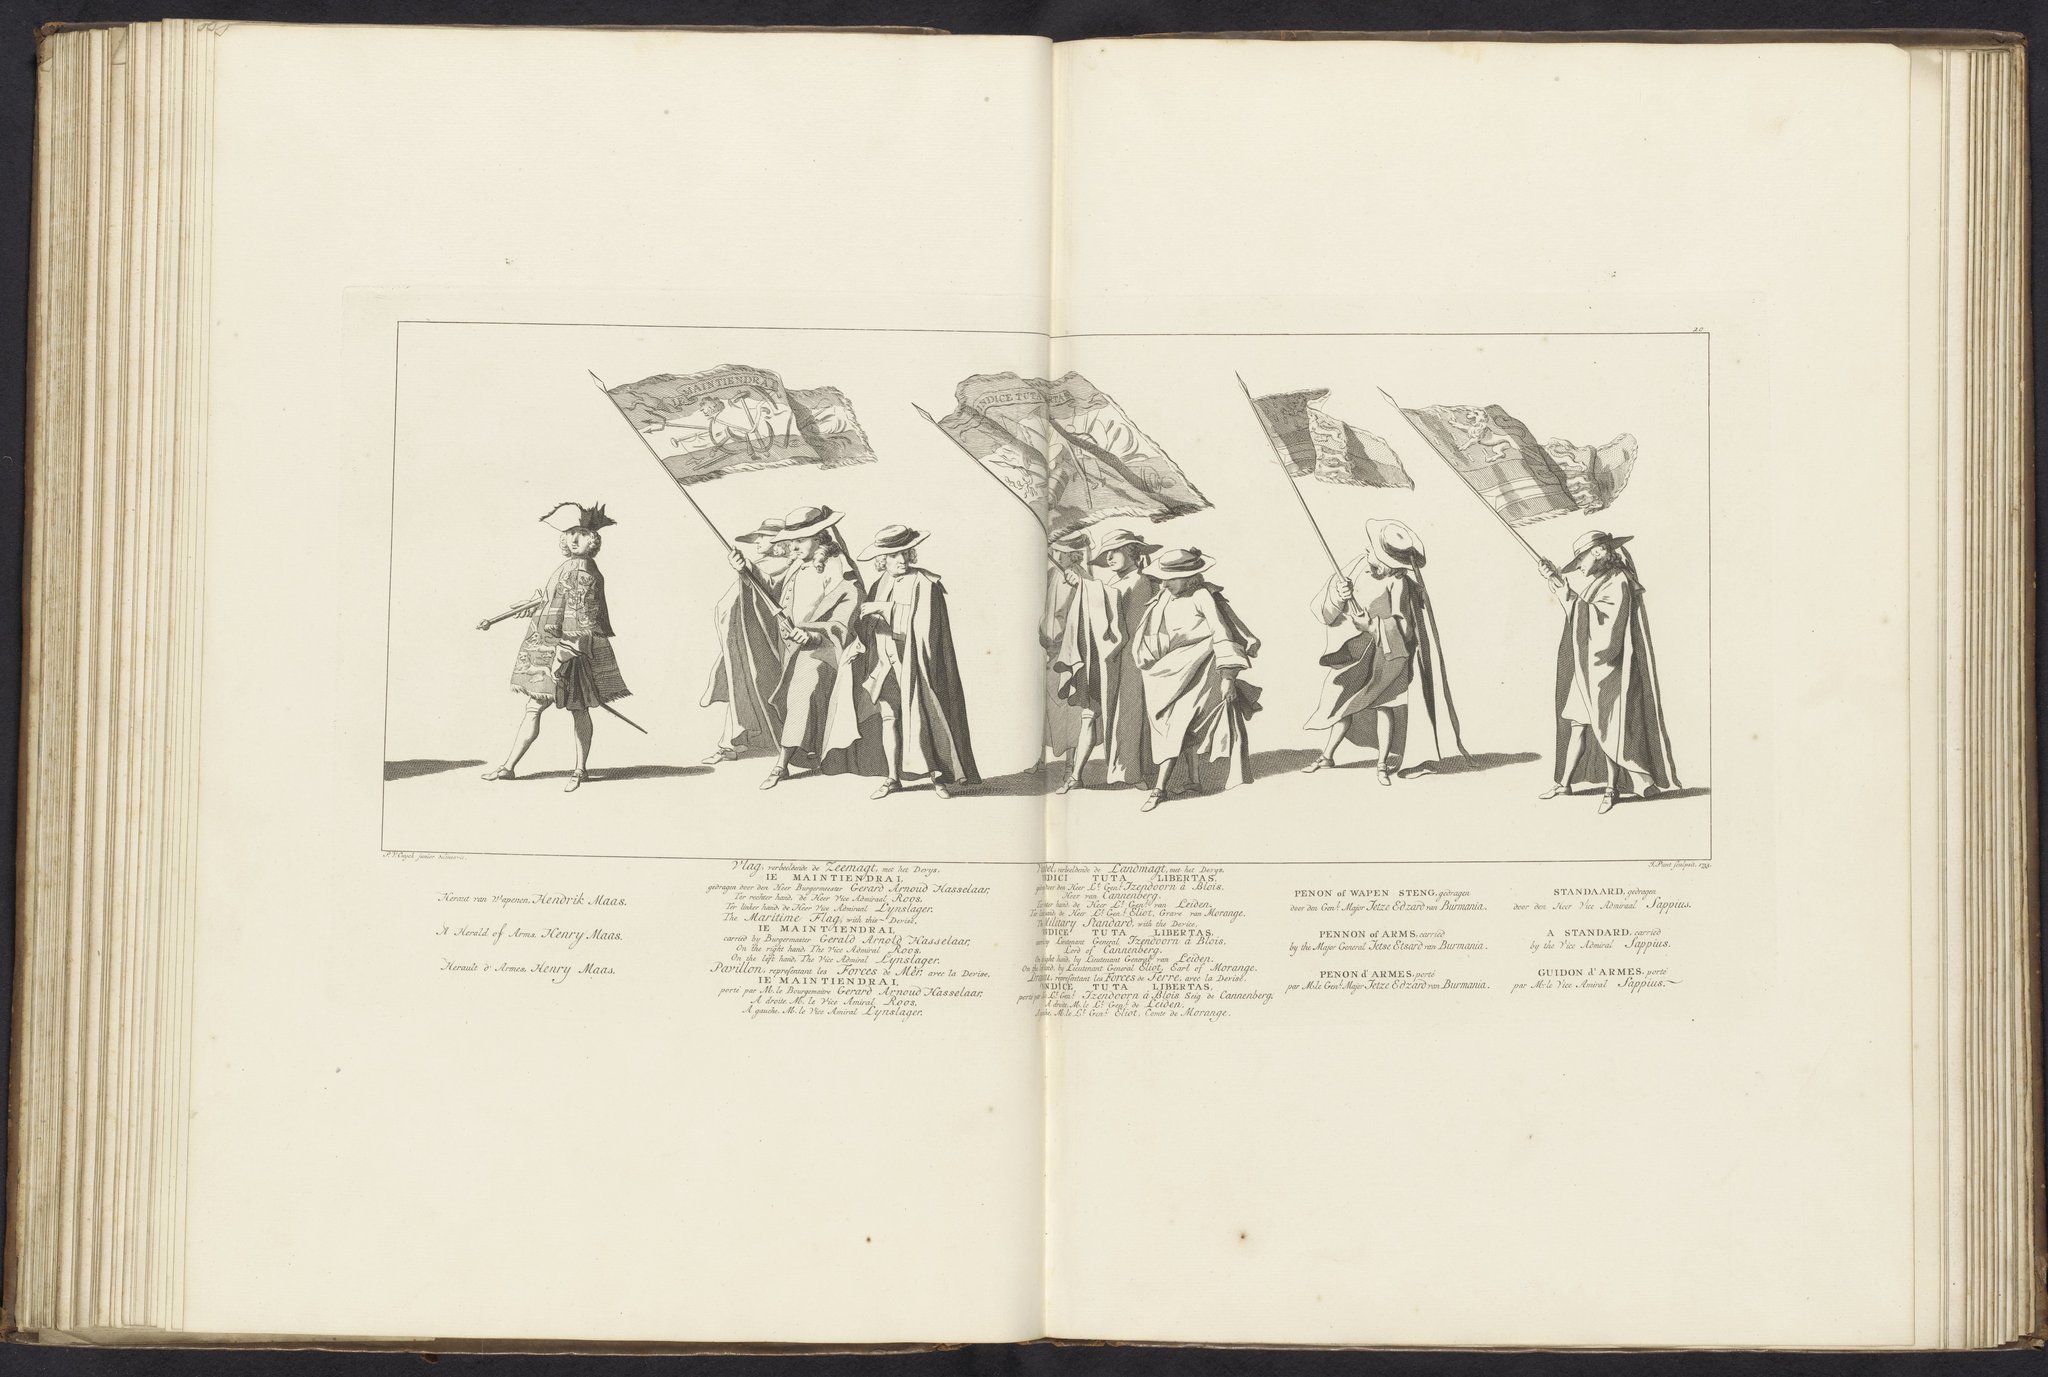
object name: print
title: Lijkstatie van Willem IV, 1752, plaat 20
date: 1753-1755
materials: paper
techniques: engraving, etching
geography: northern netherlands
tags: willem iv (prins van oranje-nassau), cortege, funeral procession, insignia and symbols of sovereignty (crown, diadem, sceptre, orb, seal, standard, cloak, pectoral), delft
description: Heraut gevolgd door de dragers van vaandels van de zeemacht en landmacht. In de marge het onderschrift in Nederlands, Frans en Engels. Onderdeel van een serie van 41 platen van de begrafenisstoet van stadhouder Willem IV te Delft op 4 februari 1752. Genummerd rechtsboven: 20. In de gebonden uitgave van 1755.